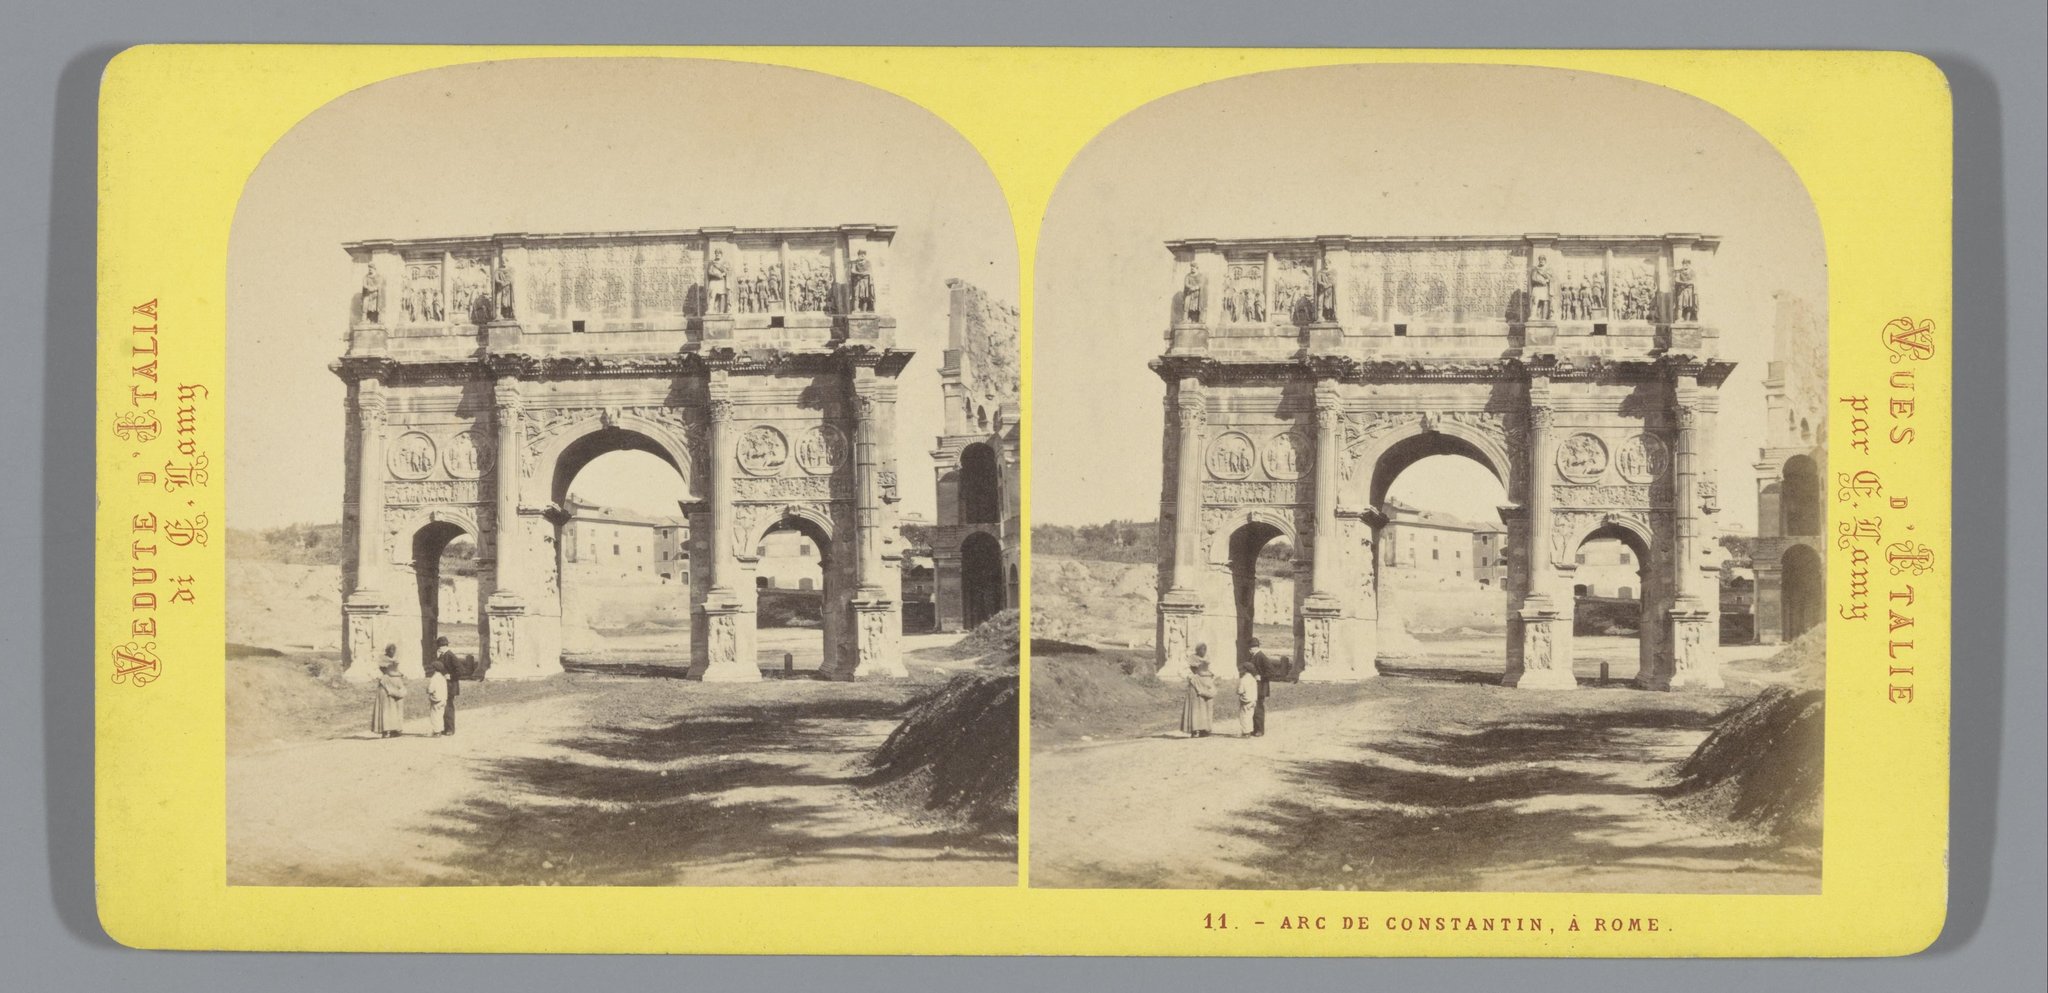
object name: stereograph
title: Boog van Constantijn, Rome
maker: ernest eléonor pierre lamy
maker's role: publisher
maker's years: 1828-1900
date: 1861-1878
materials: cardboard, paper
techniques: albumen print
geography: rome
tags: triumphal arch, arch of constantine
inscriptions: number: ‘11.’